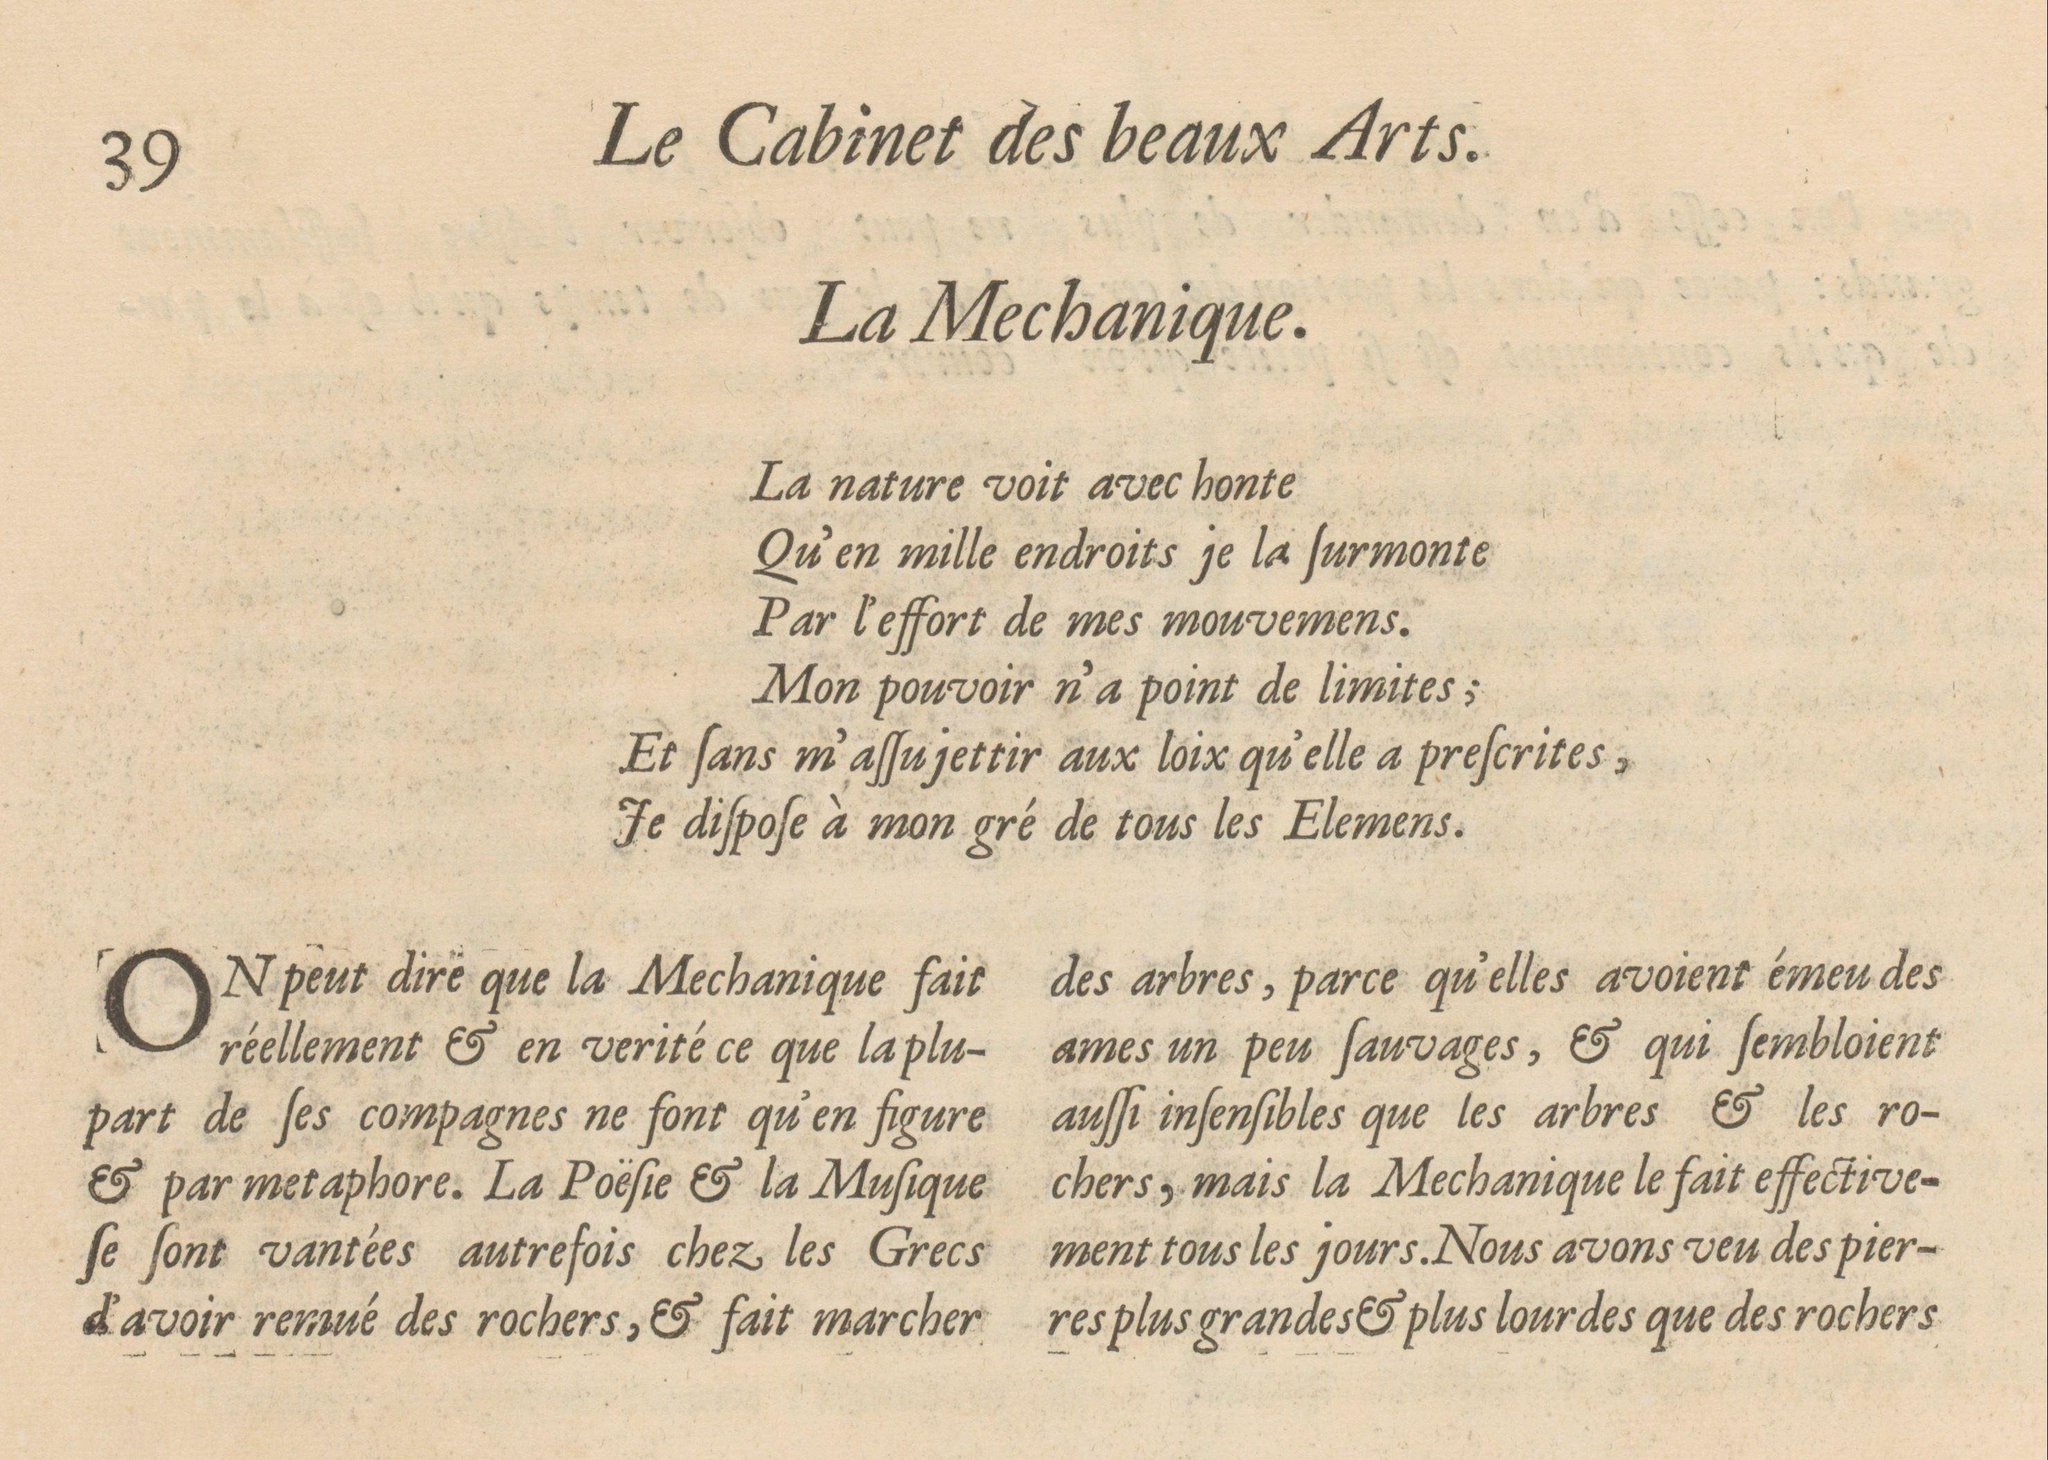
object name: album leaf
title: Tekstblad met verklaring van de prent over Mechanica, p. 39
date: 1695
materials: paper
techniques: letterpress printing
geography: paris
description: Verklaring van de prent met voorstelling van Mechanica in het Frans. Pagina 39. Tekstblad maakt deel uit van een album.